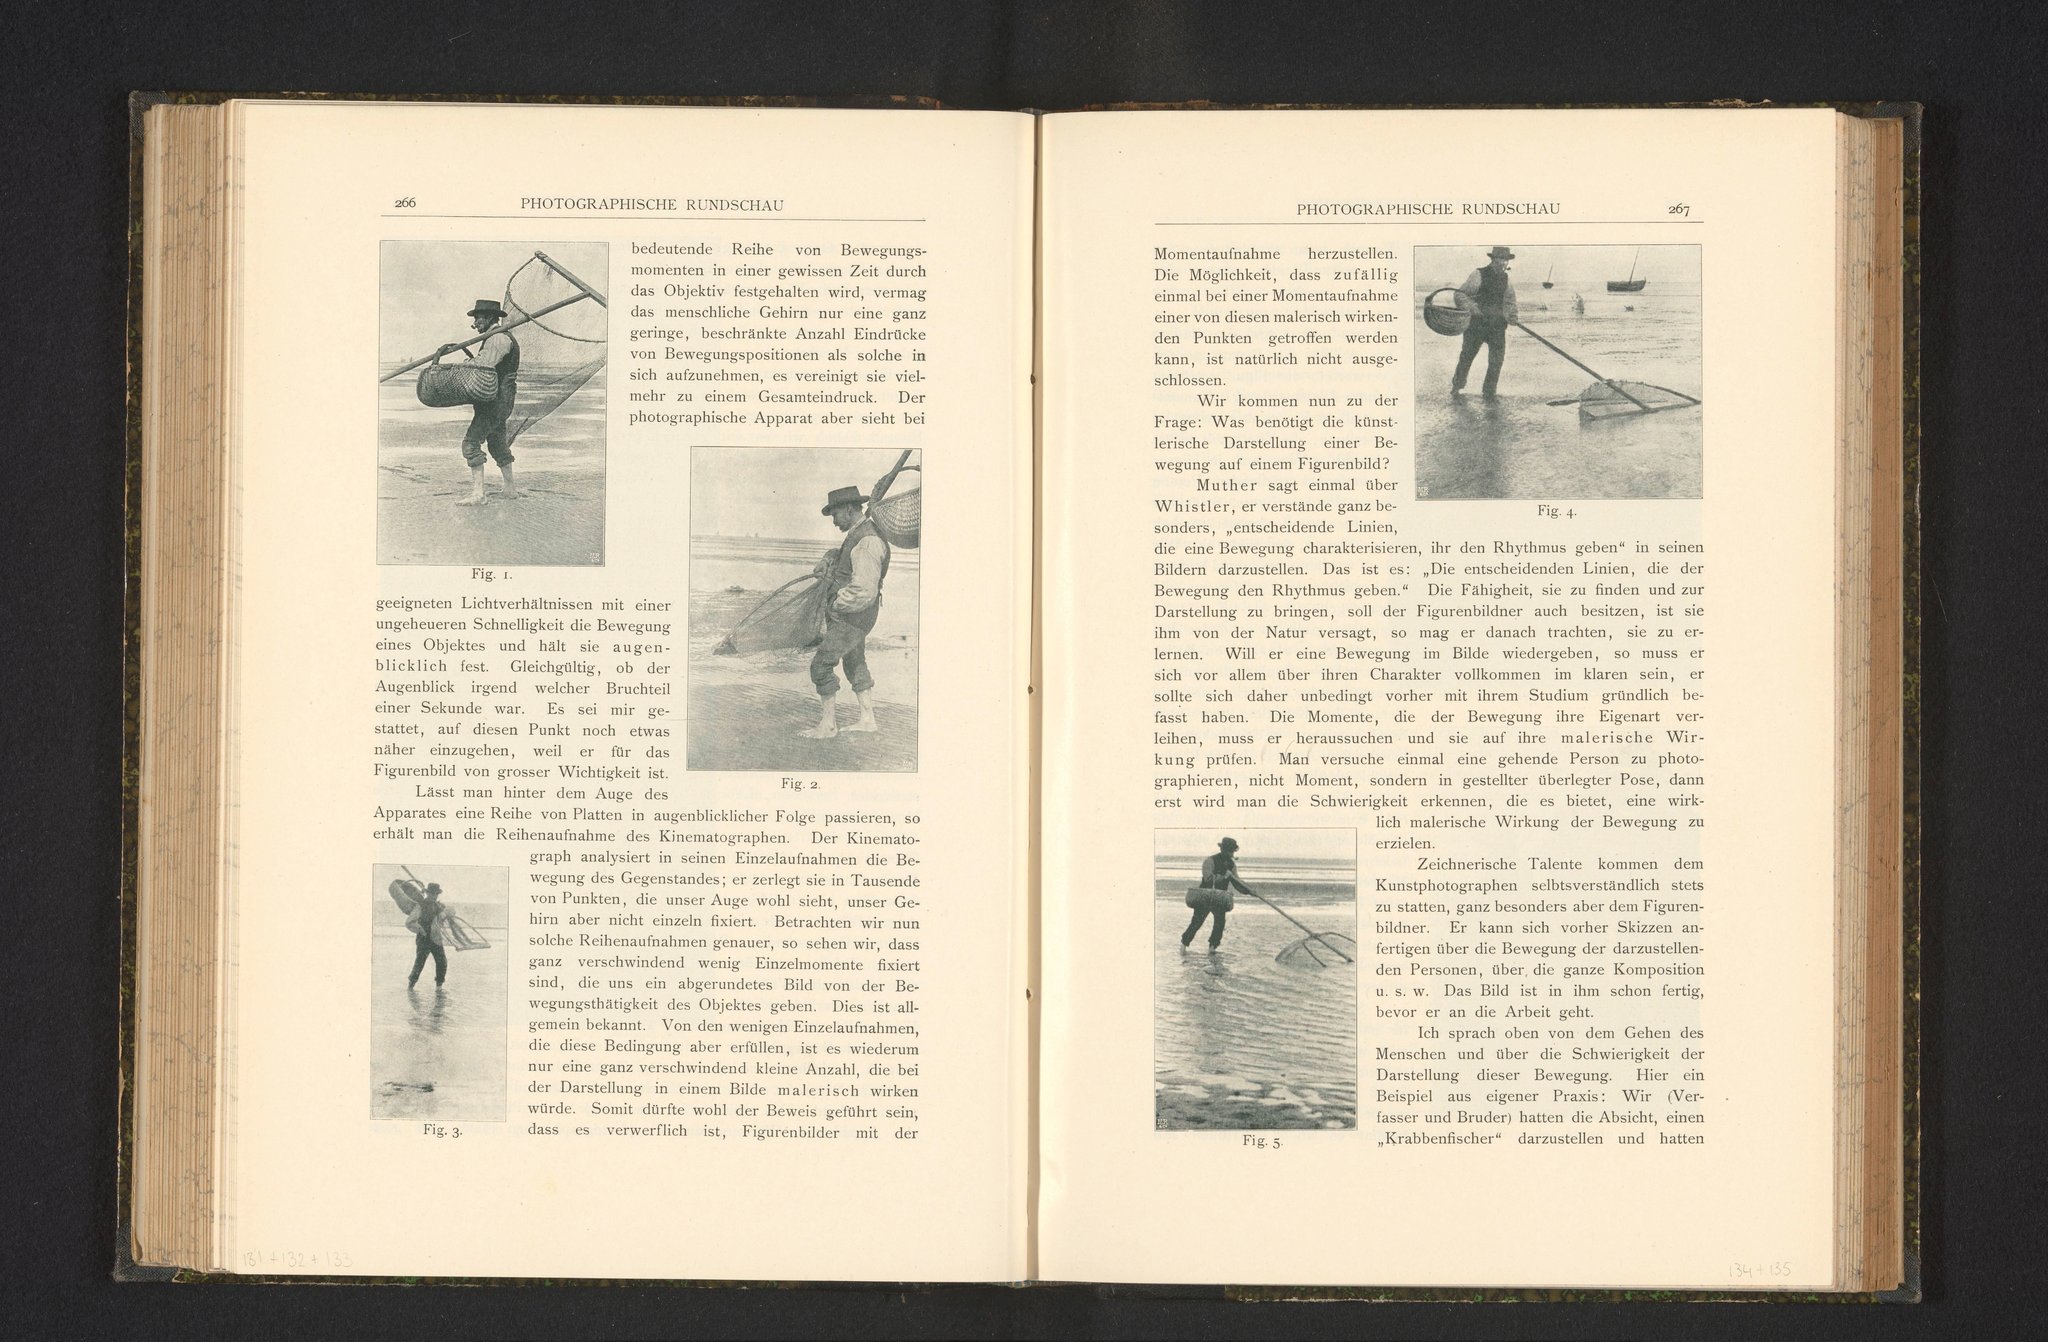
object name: page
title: Gezicht op een visser aan de kust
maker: Anonymous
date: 1893-1898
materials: paper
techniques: autotype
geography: berlin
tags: coast, fisherman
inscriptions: monogram: ‘MR/ &Co’